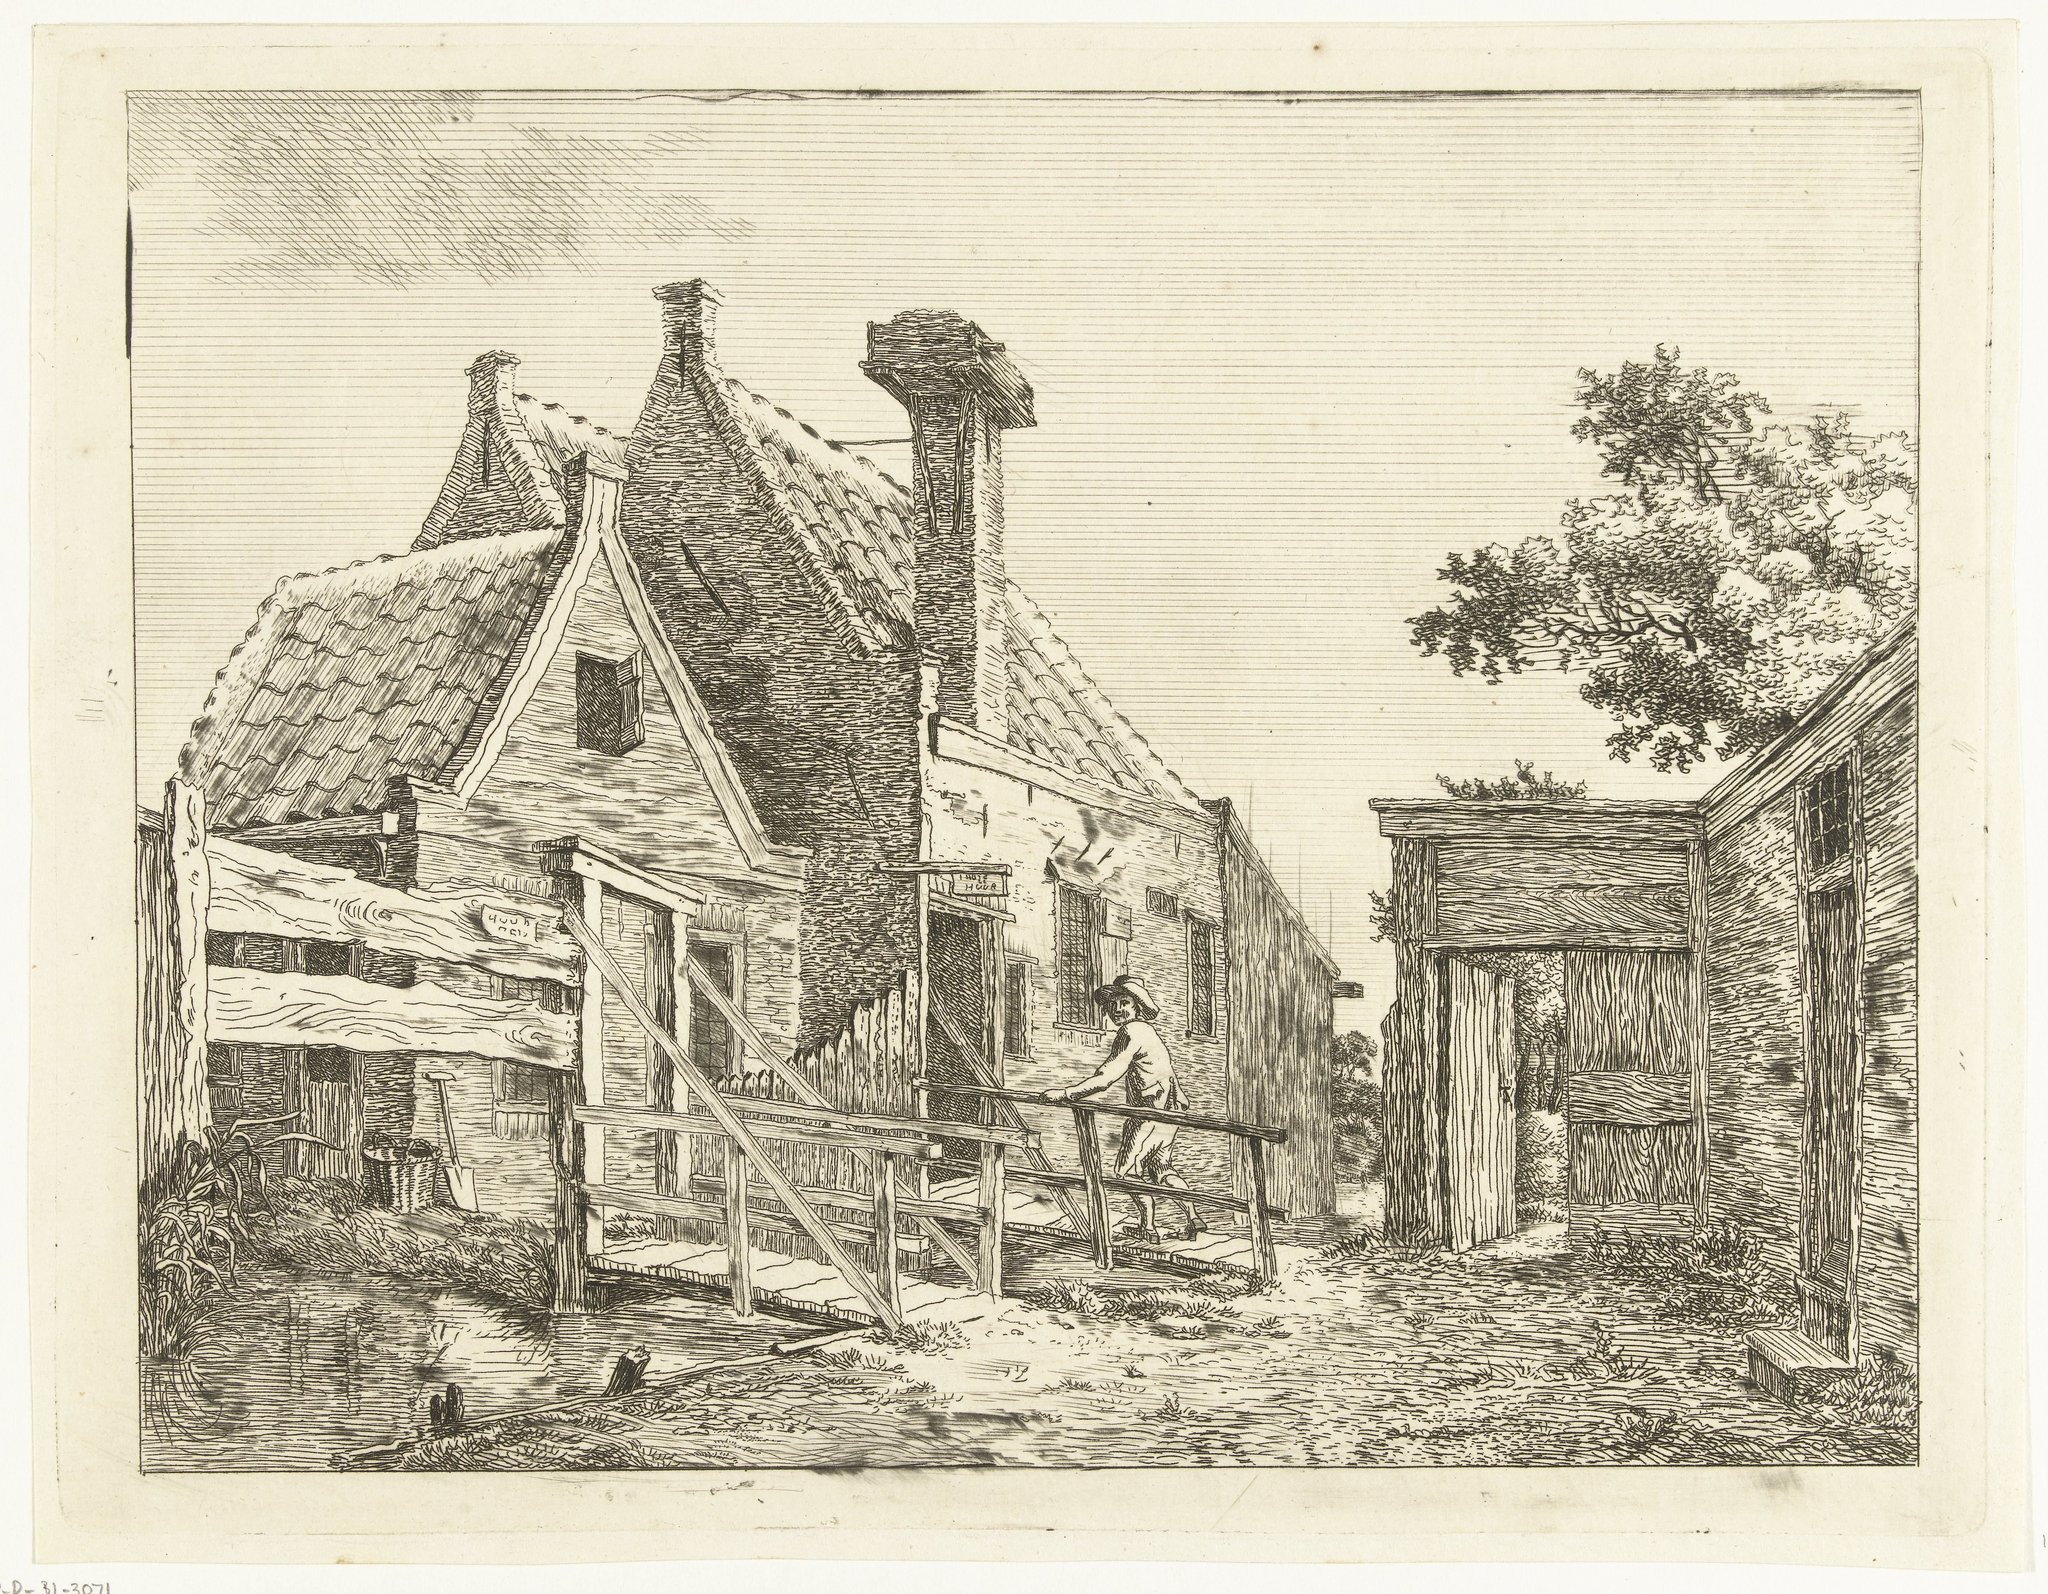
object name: print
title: Jongetje loopt over houten brug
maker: anthonie van den bos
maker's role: draughtsman, print maker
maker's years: 1763-1838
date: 1778-1838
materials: paper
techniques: drypoint, etching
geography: netherlands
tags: bridge (+ one person ~ traffic and transport)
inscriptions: collector's mark: Lugt 2228